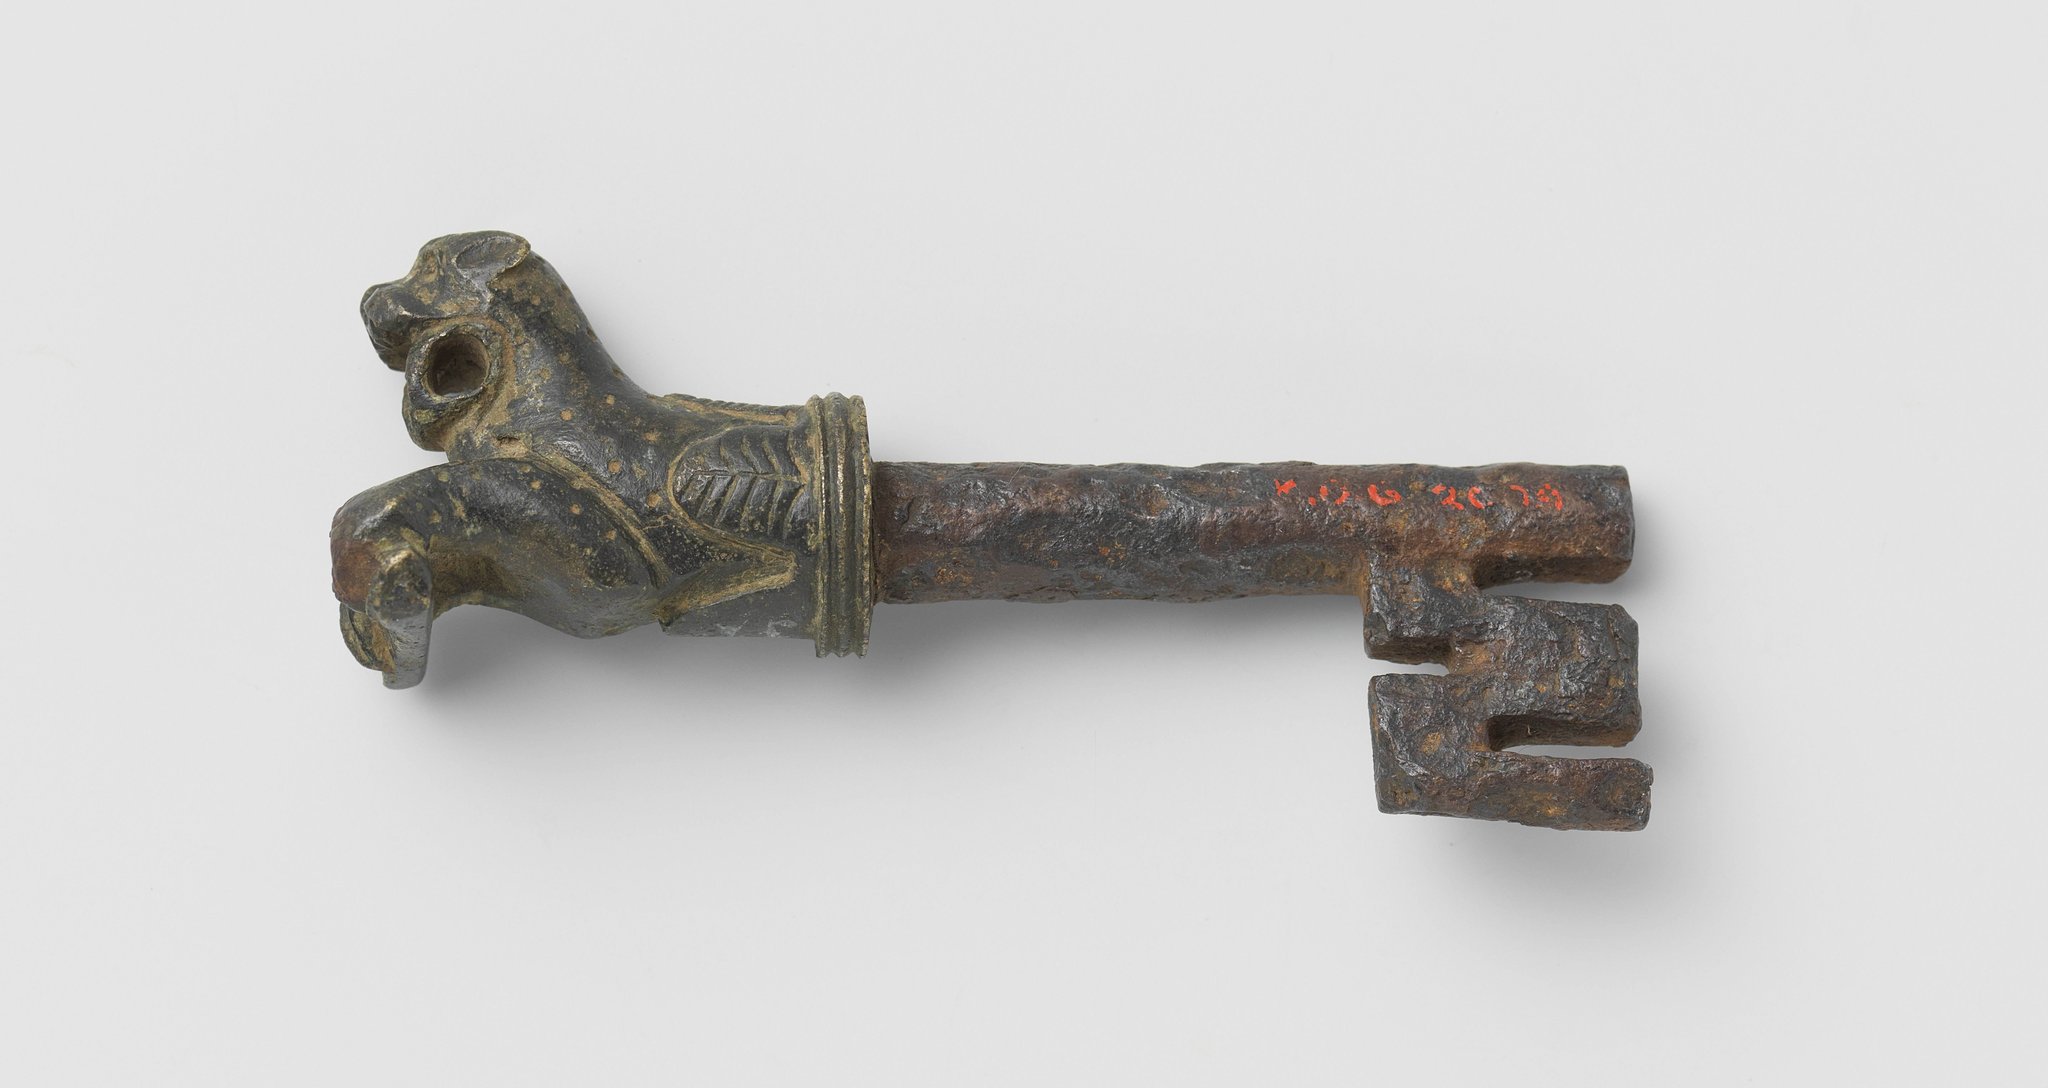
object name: key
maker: Anonymous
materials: bronze, iron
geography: rome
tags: ornament derived from animal forms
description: Sleutel waarvan de greep bestaat uit het voorgedeelte van een tijger gevat in een bladerkrans. Hij heeft vermoedelijk een ring in de bek gehad. Greep van brons en pijp en baard van ijzer.